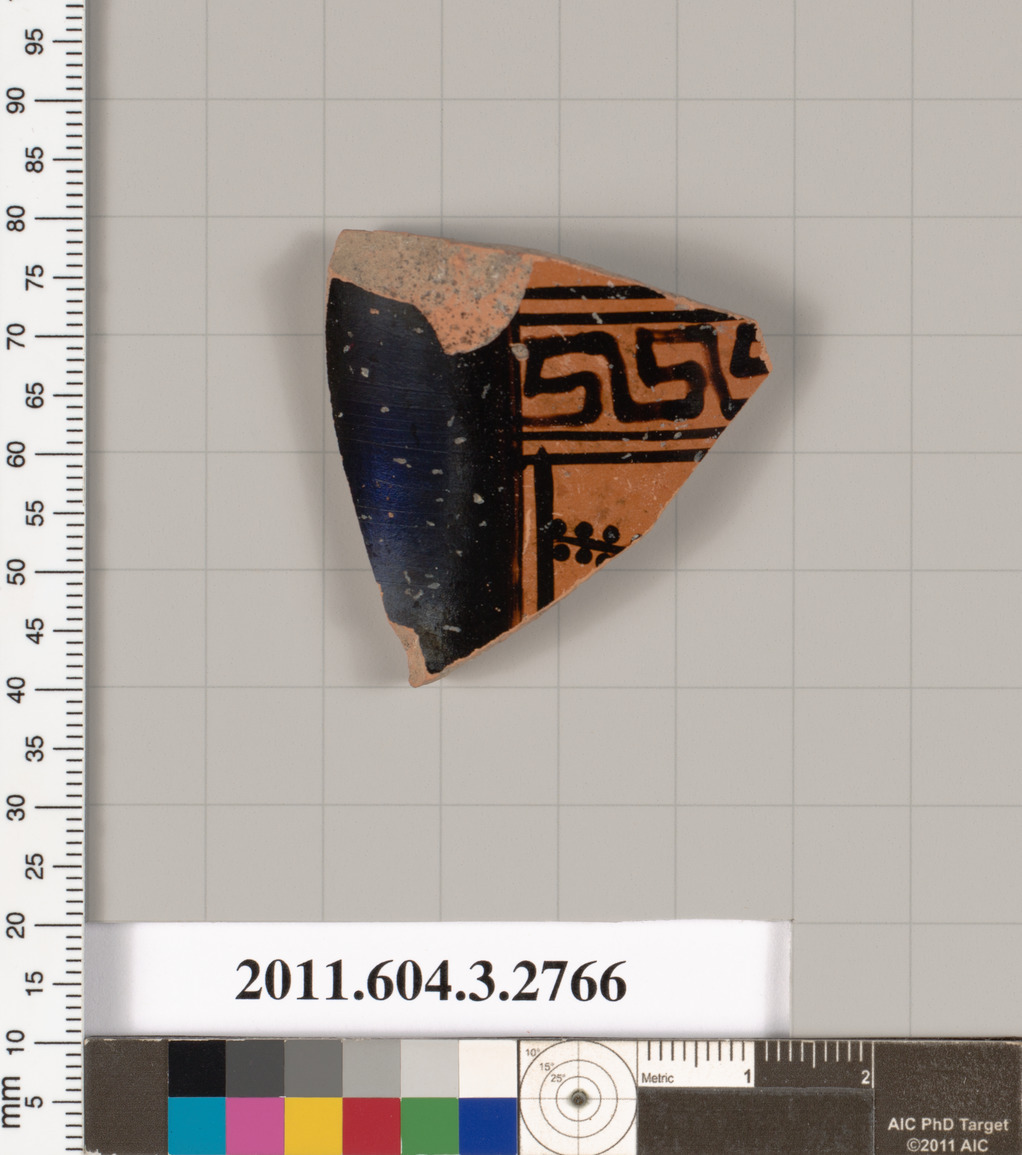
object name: olpe fragment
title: Terracotta fragment of an olpe (jug)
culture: greek, attic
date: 530-520 BCE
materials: terracotta